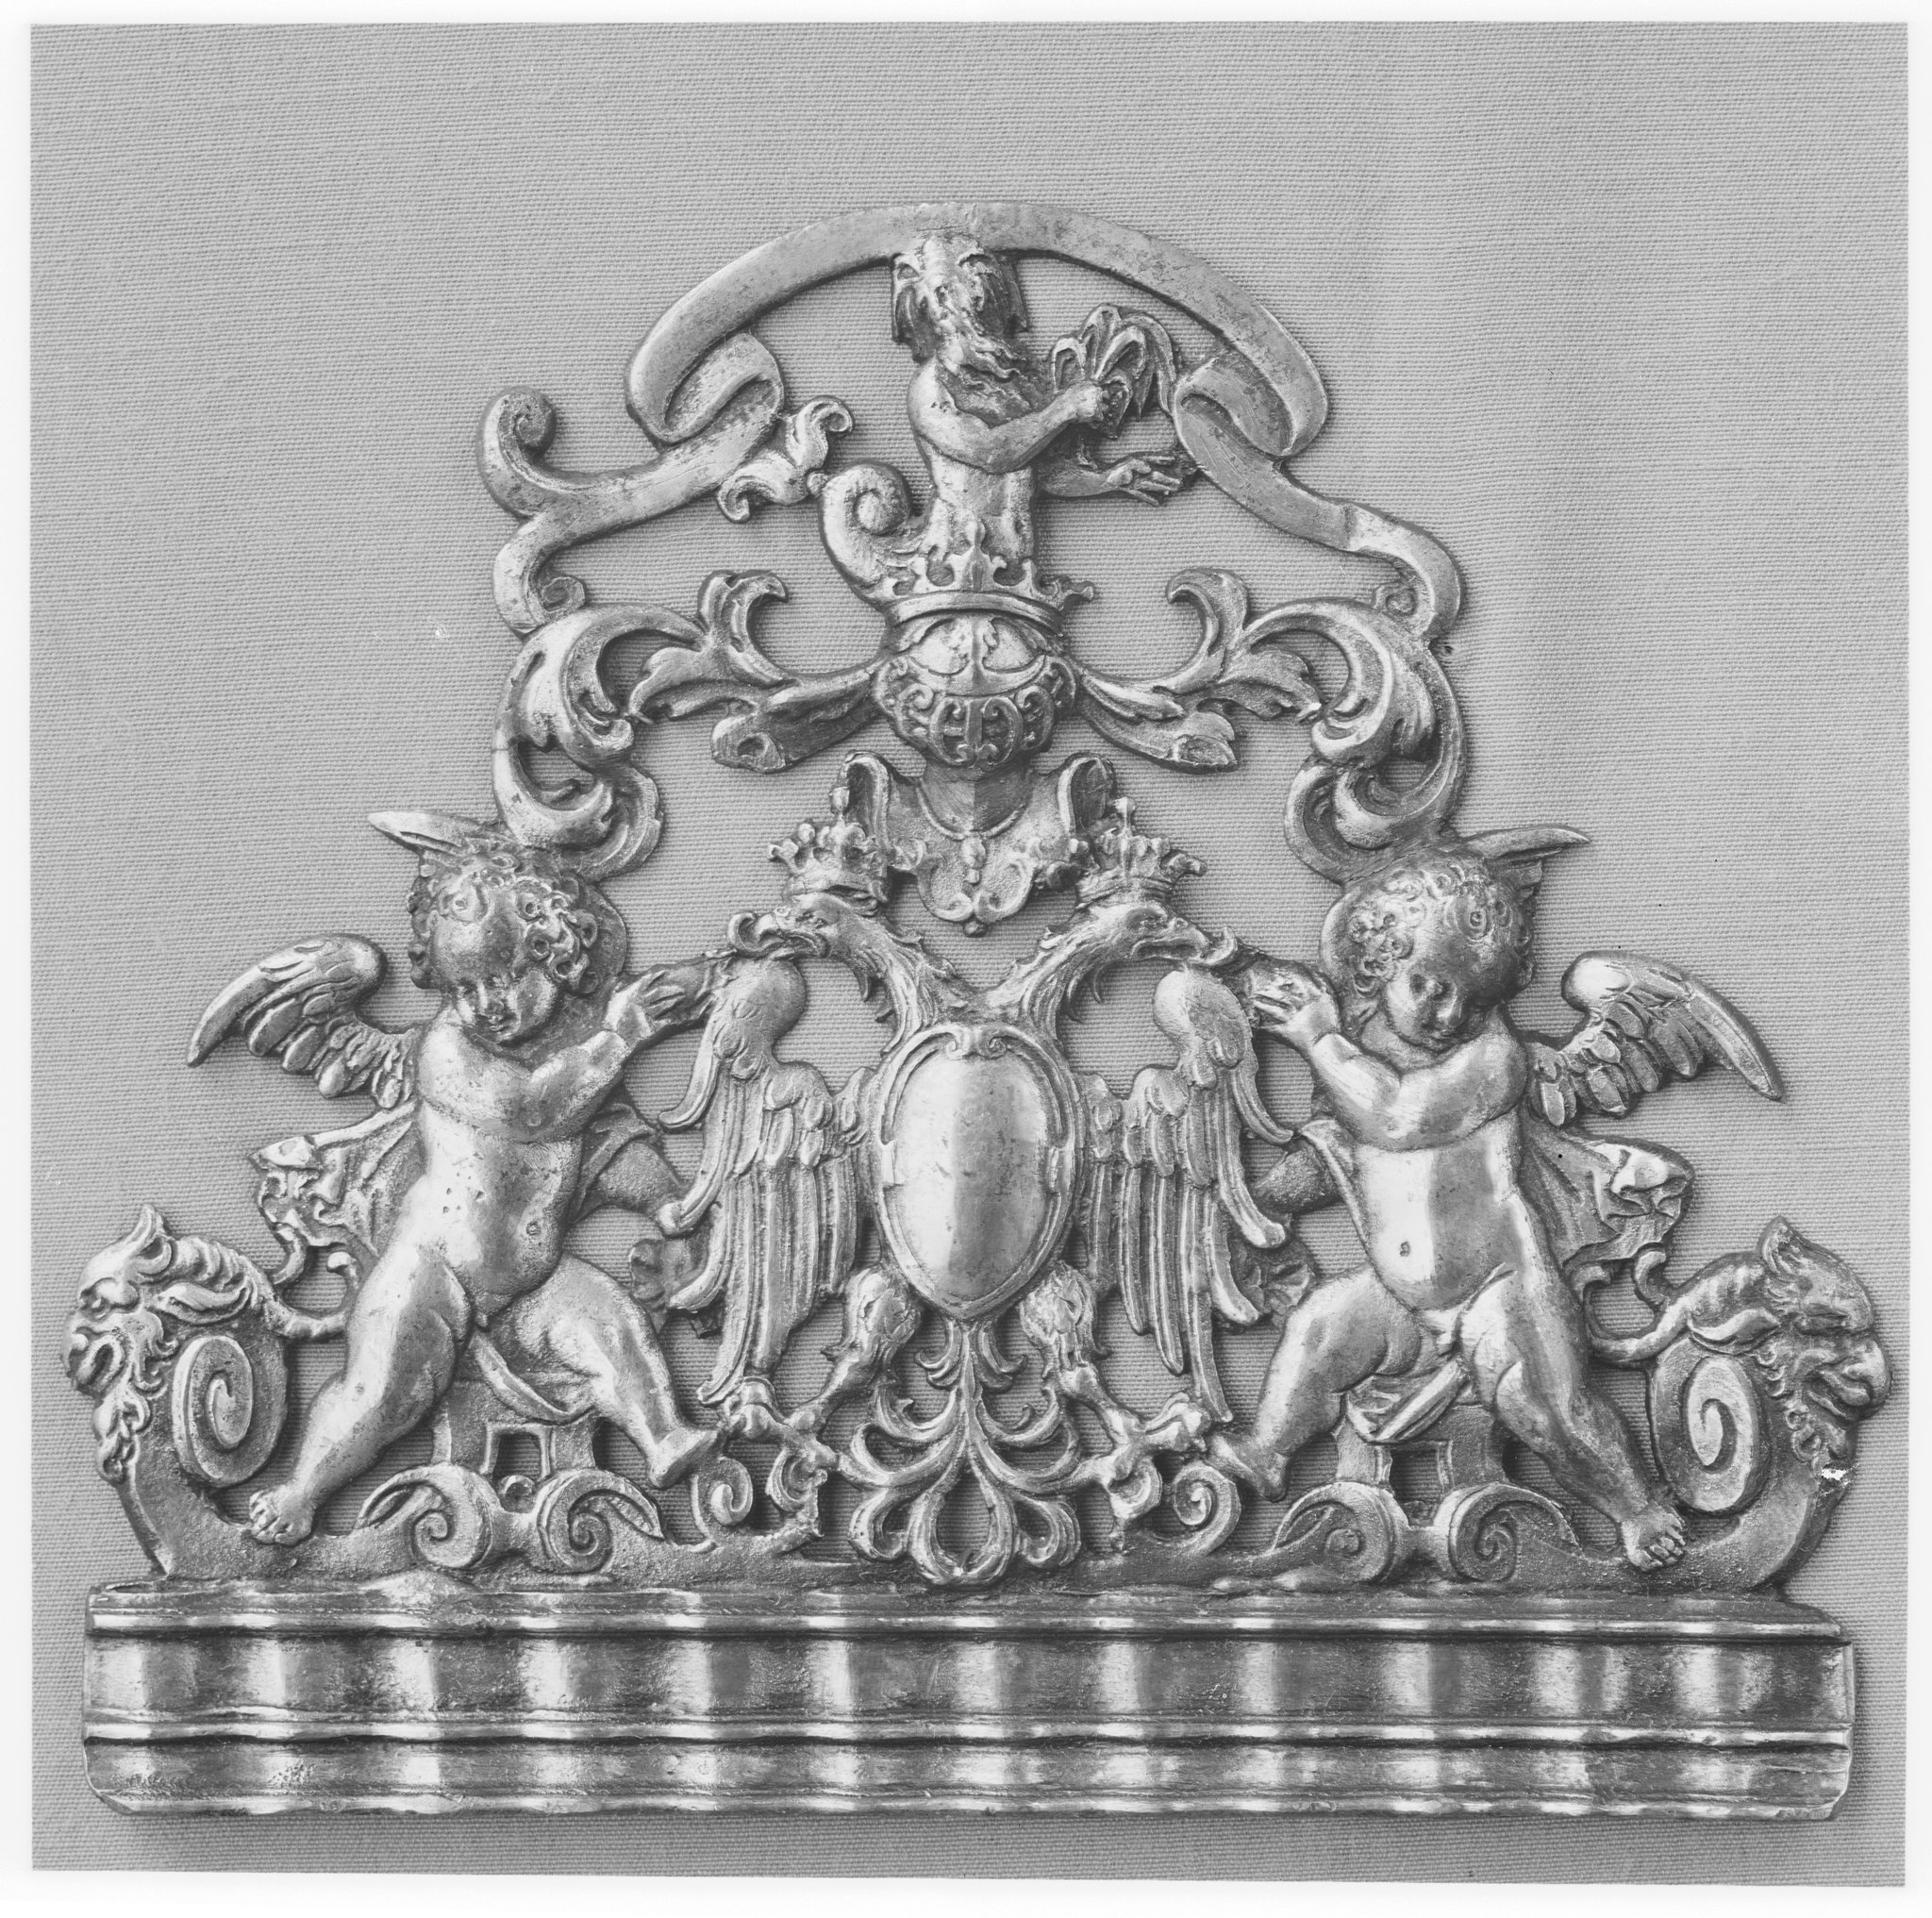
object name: clock pediment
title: Clock pediment or fret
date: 1601-1700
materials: gilt bronze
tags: putti